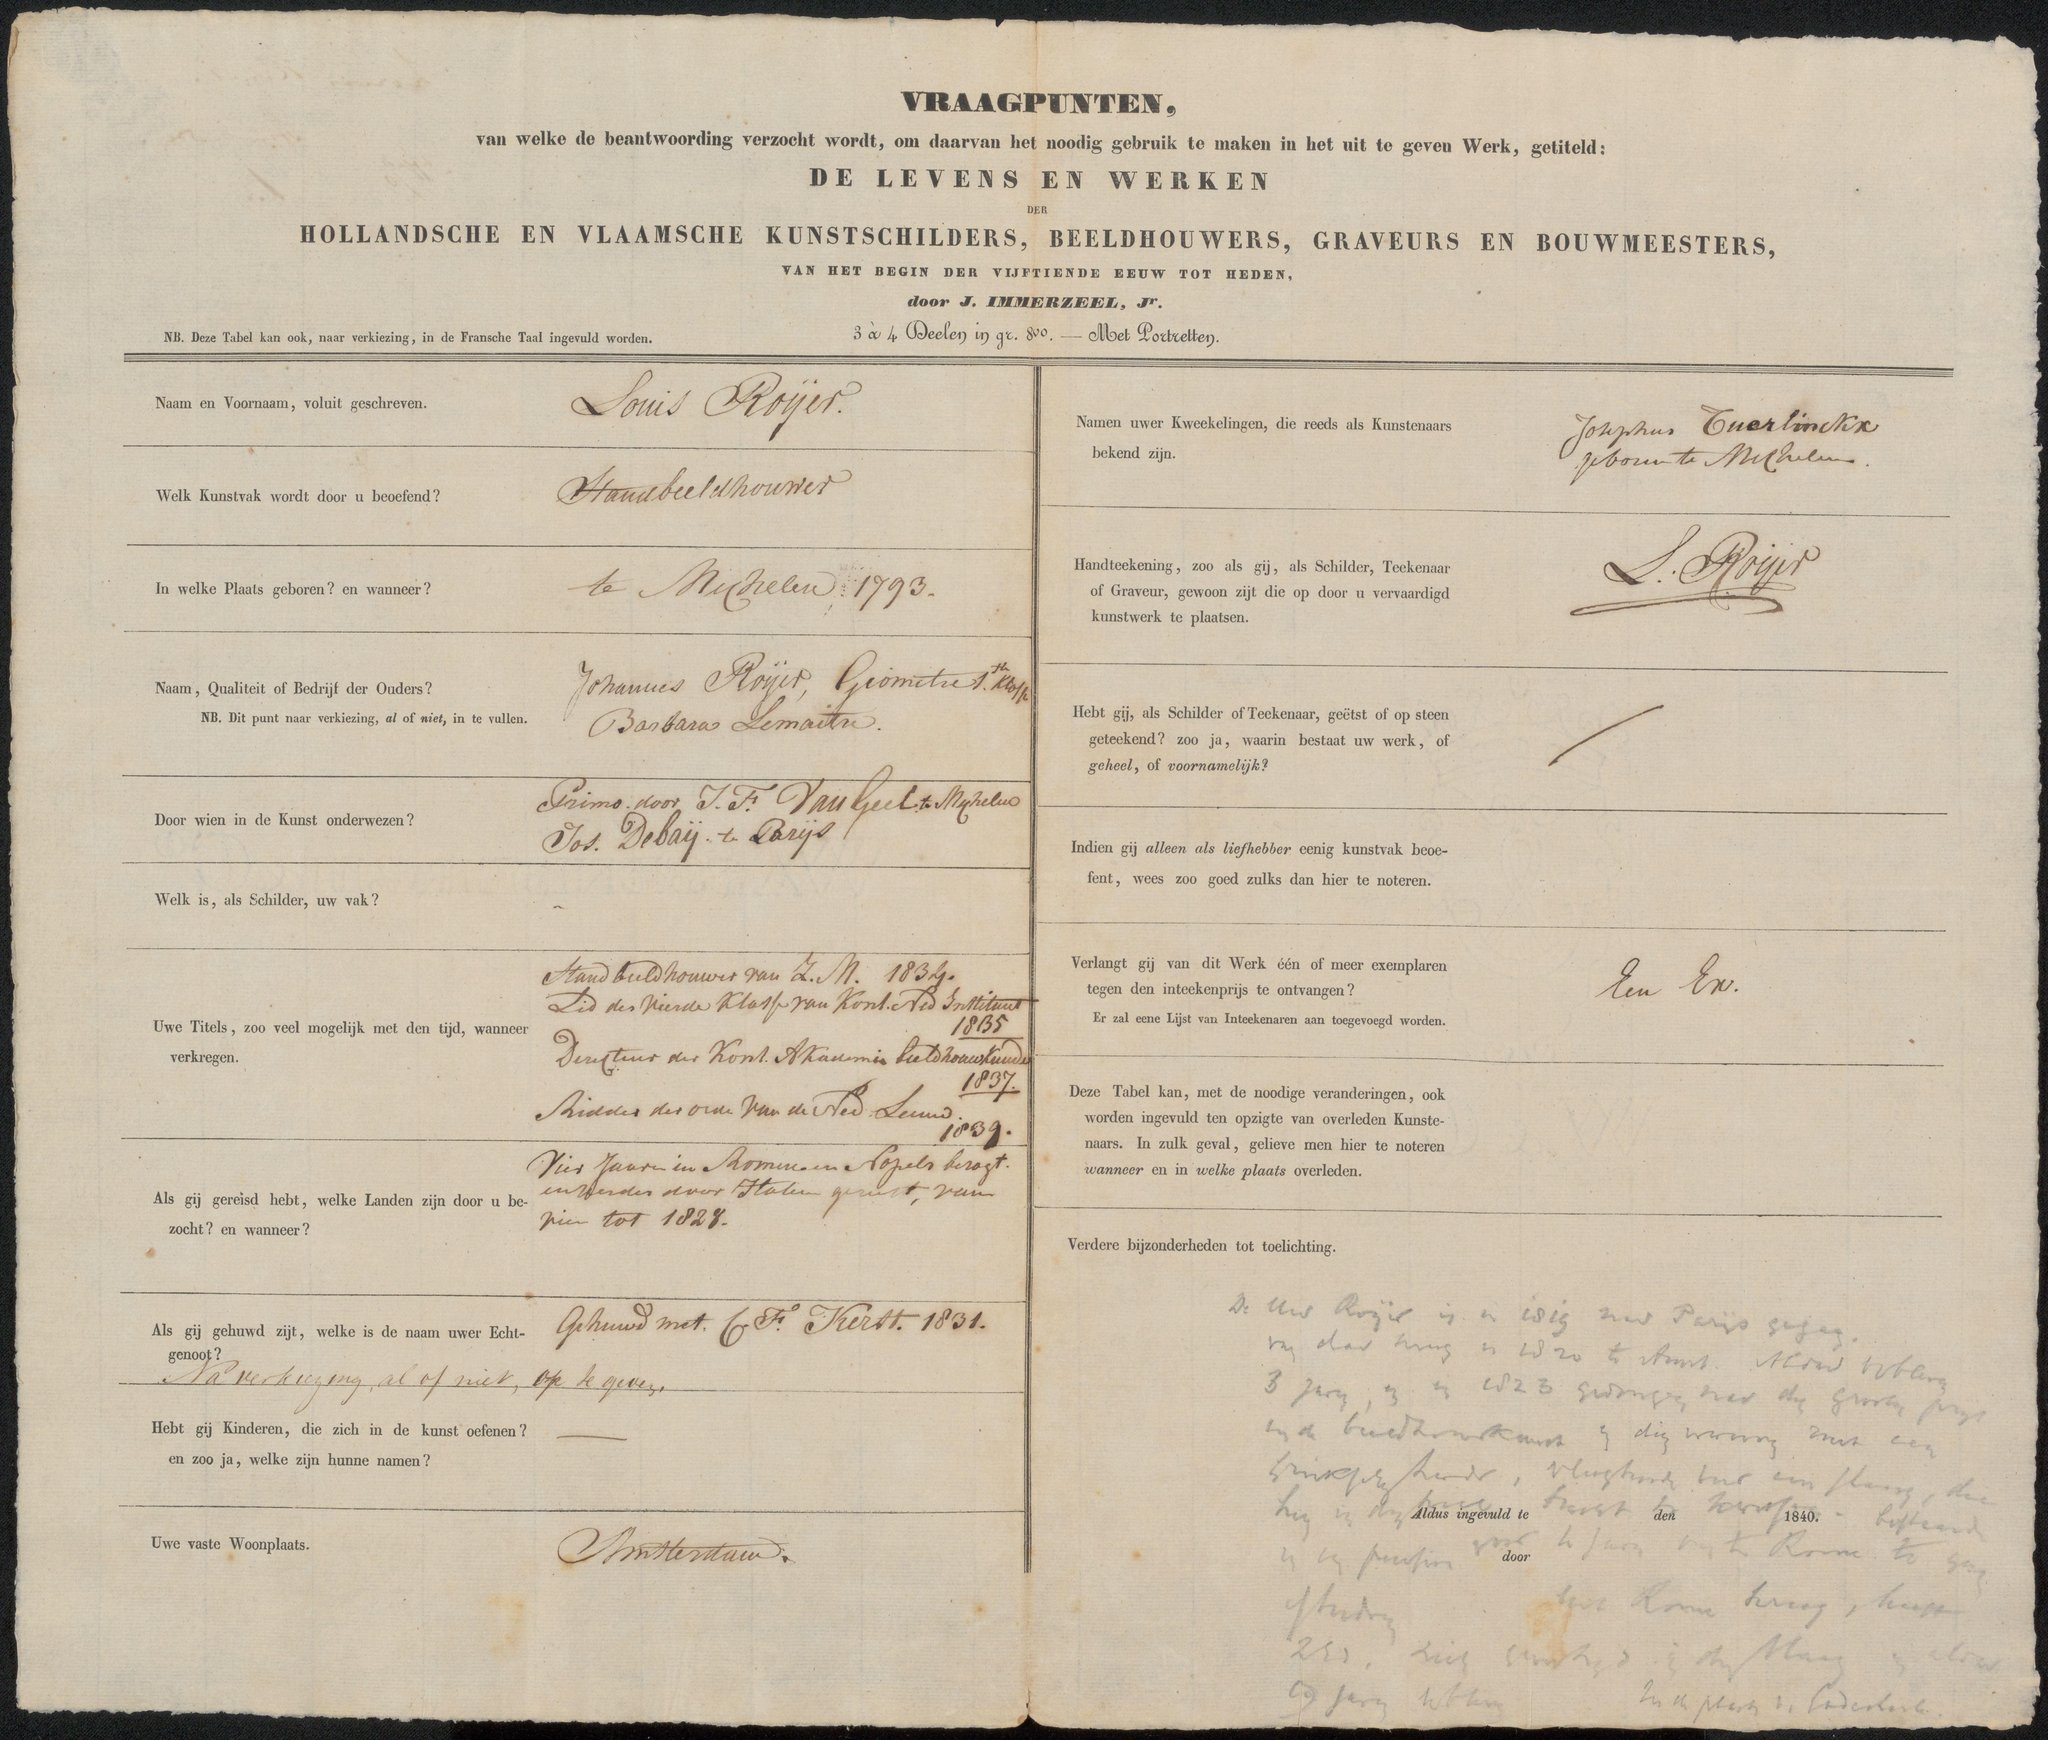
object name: manuscript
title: Enquêteformulier ingevuld door Louis Royer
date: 1840-1841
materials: ink, paper, pencil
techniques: pen, printing, writing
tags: mechelen, draughtsman, sculptor, louis royer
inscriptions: inscription: ‘Vraagpunten,/ van welke de beantwoording verzocht wordt, om daarvan het noodig gebruik te maken in het uit te geven Werk, getiteld: De levens en werken/ der Hollandsche en Vlaamsche kunstschilders, beeldhouwers,/ graveurs en bouwmeesters, van het begin der vijftiende eeuw tot heden/ door J. Immerzeel, Jr.’, watermark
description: Opgenomen in: Immerzeel, J. Jr., De levens en werken der Hollandsche en Vlaamsche kunstschilders, beeldhouwers, graveurs en bouwmeesters, van het begin der vijftiende eeuw tot heden, Amsterdam: J.C. van Kesteren, 1842-1843.